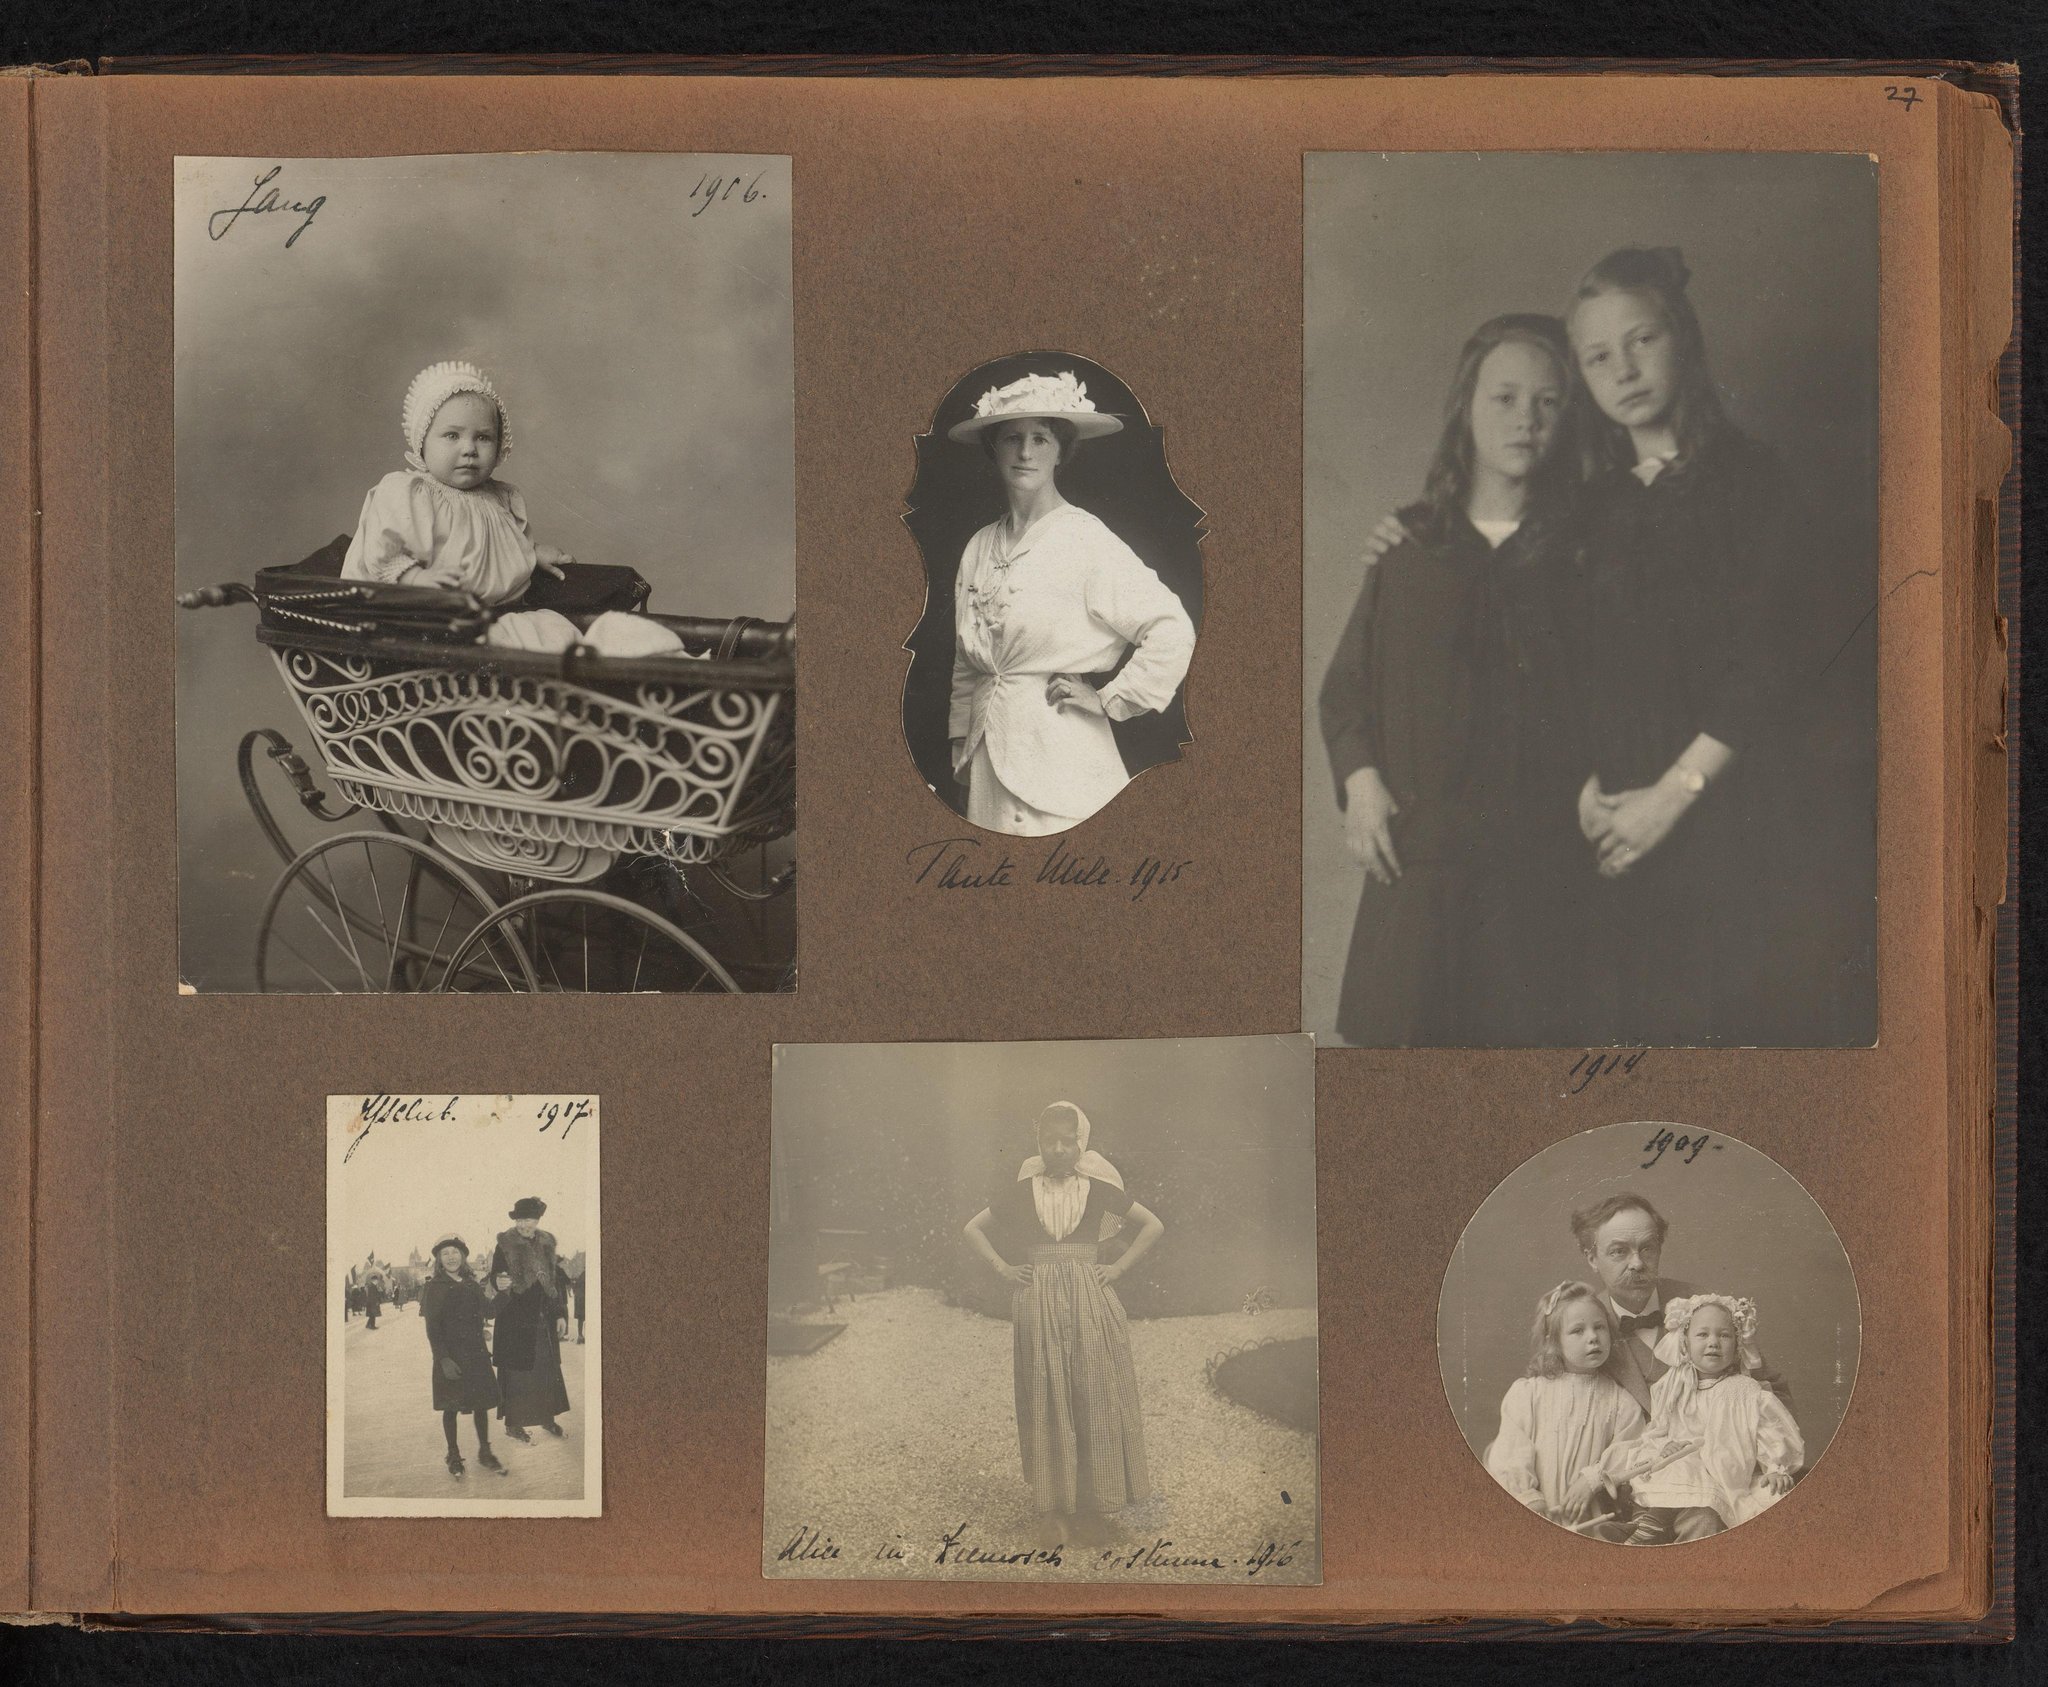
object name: album leaf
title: Bladzijde uit het fotoalbum van de familie Diepenbrock met 6 foto's van Alphons Diepenbrock en zijn omgeving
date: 1909-1917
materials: cardboard, photographic support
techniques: photography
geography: amsterdam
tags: amsterdam, alphons diepenbrock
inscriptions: inscription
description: Bruin albumblad 27 van familiealbum van Alphons Diepenbrock.